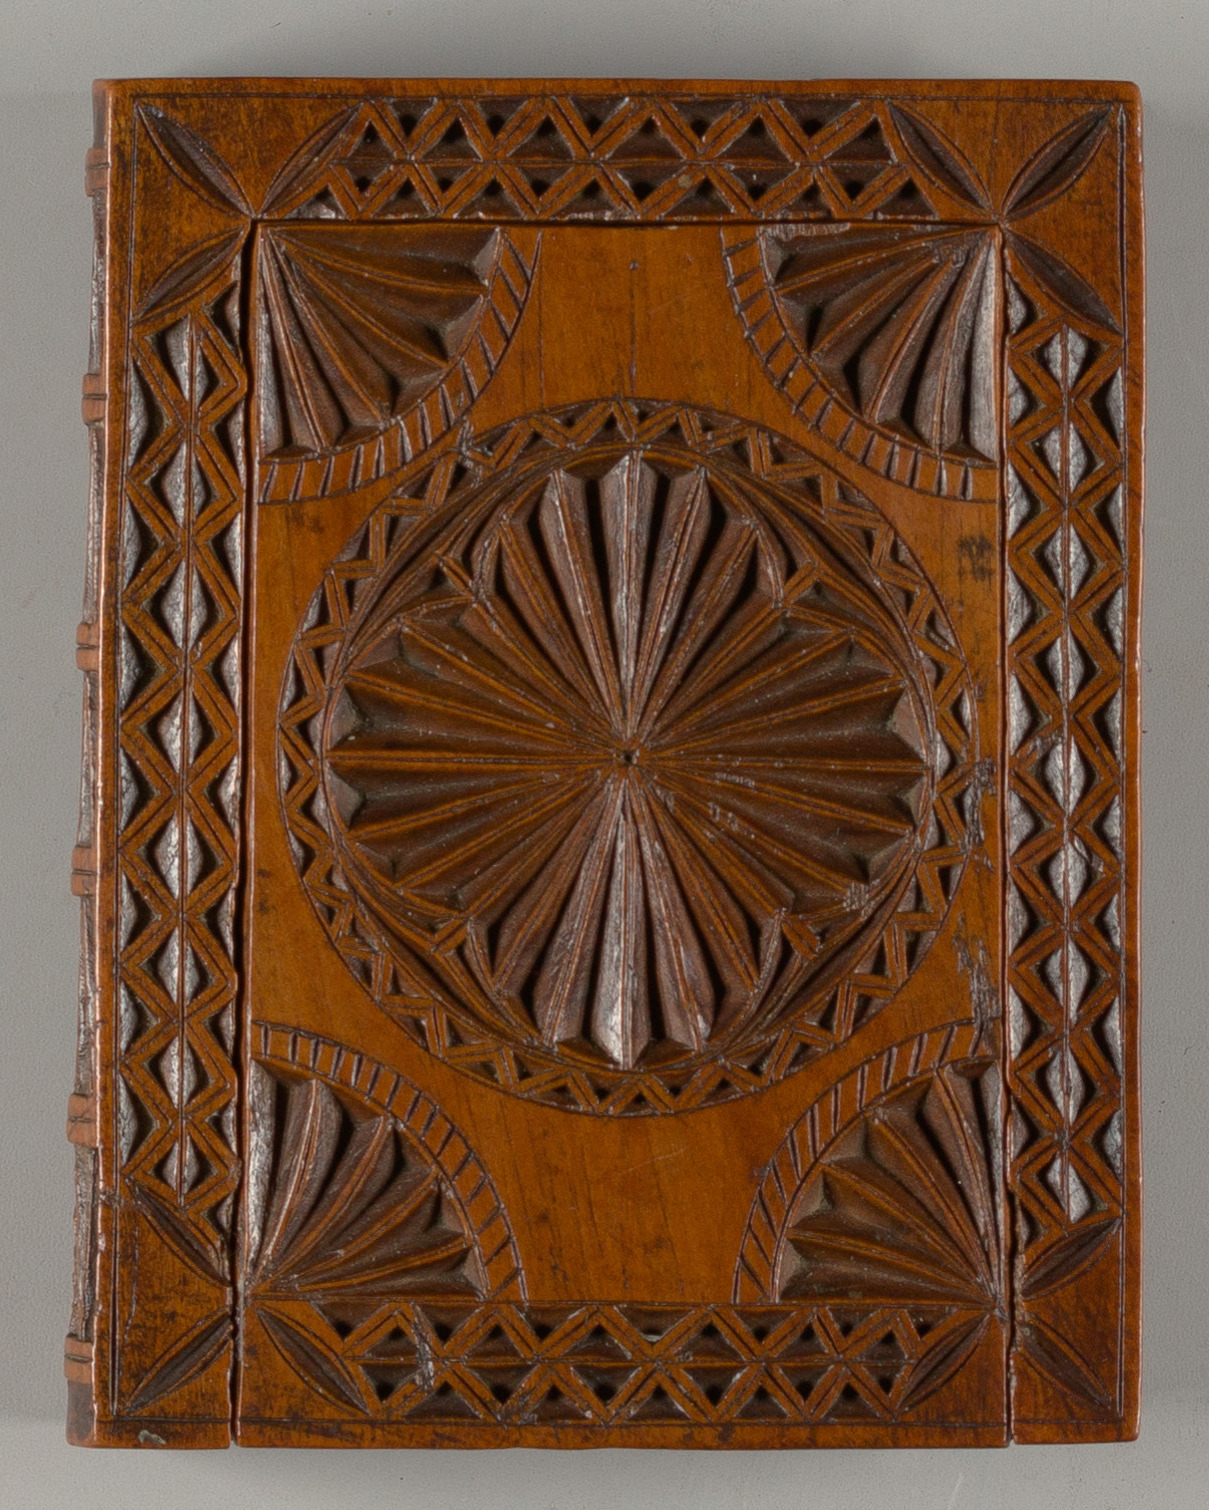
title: Box in the form of two books, with compartment and mirror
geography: europe